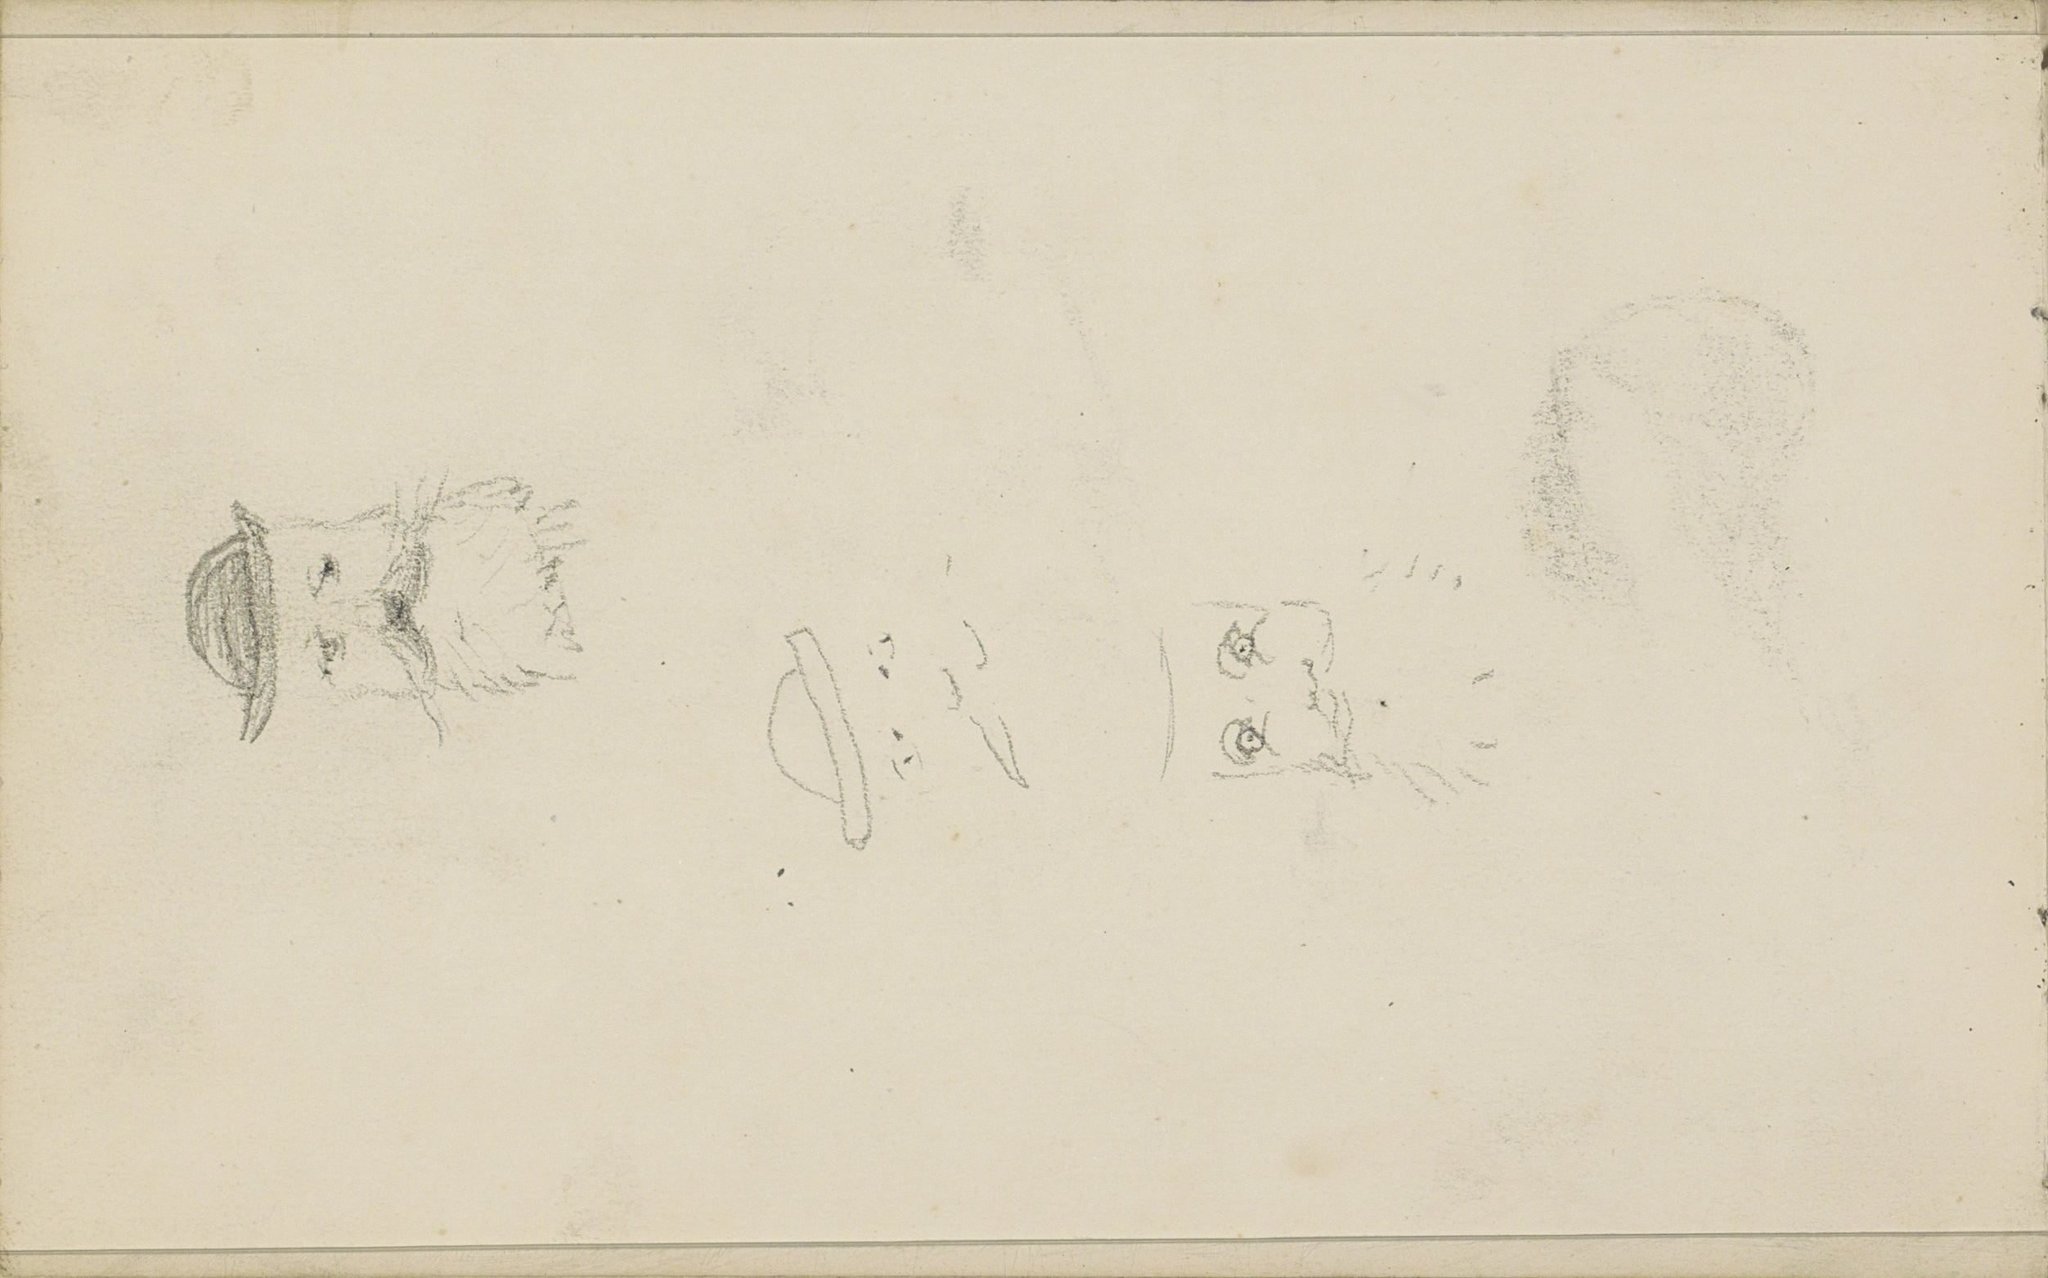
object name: sketchbook leaf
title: Drie mannenkoppen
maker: anton mauve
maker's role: draughtsman, painter, print maker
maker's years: 1838-1888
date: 1848-1888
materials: paper, pencil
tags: head (human) (+ male human being (not to be used where -a- is prescribed))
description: Blad 41 verso uit een schetsboek met 42 bladen.